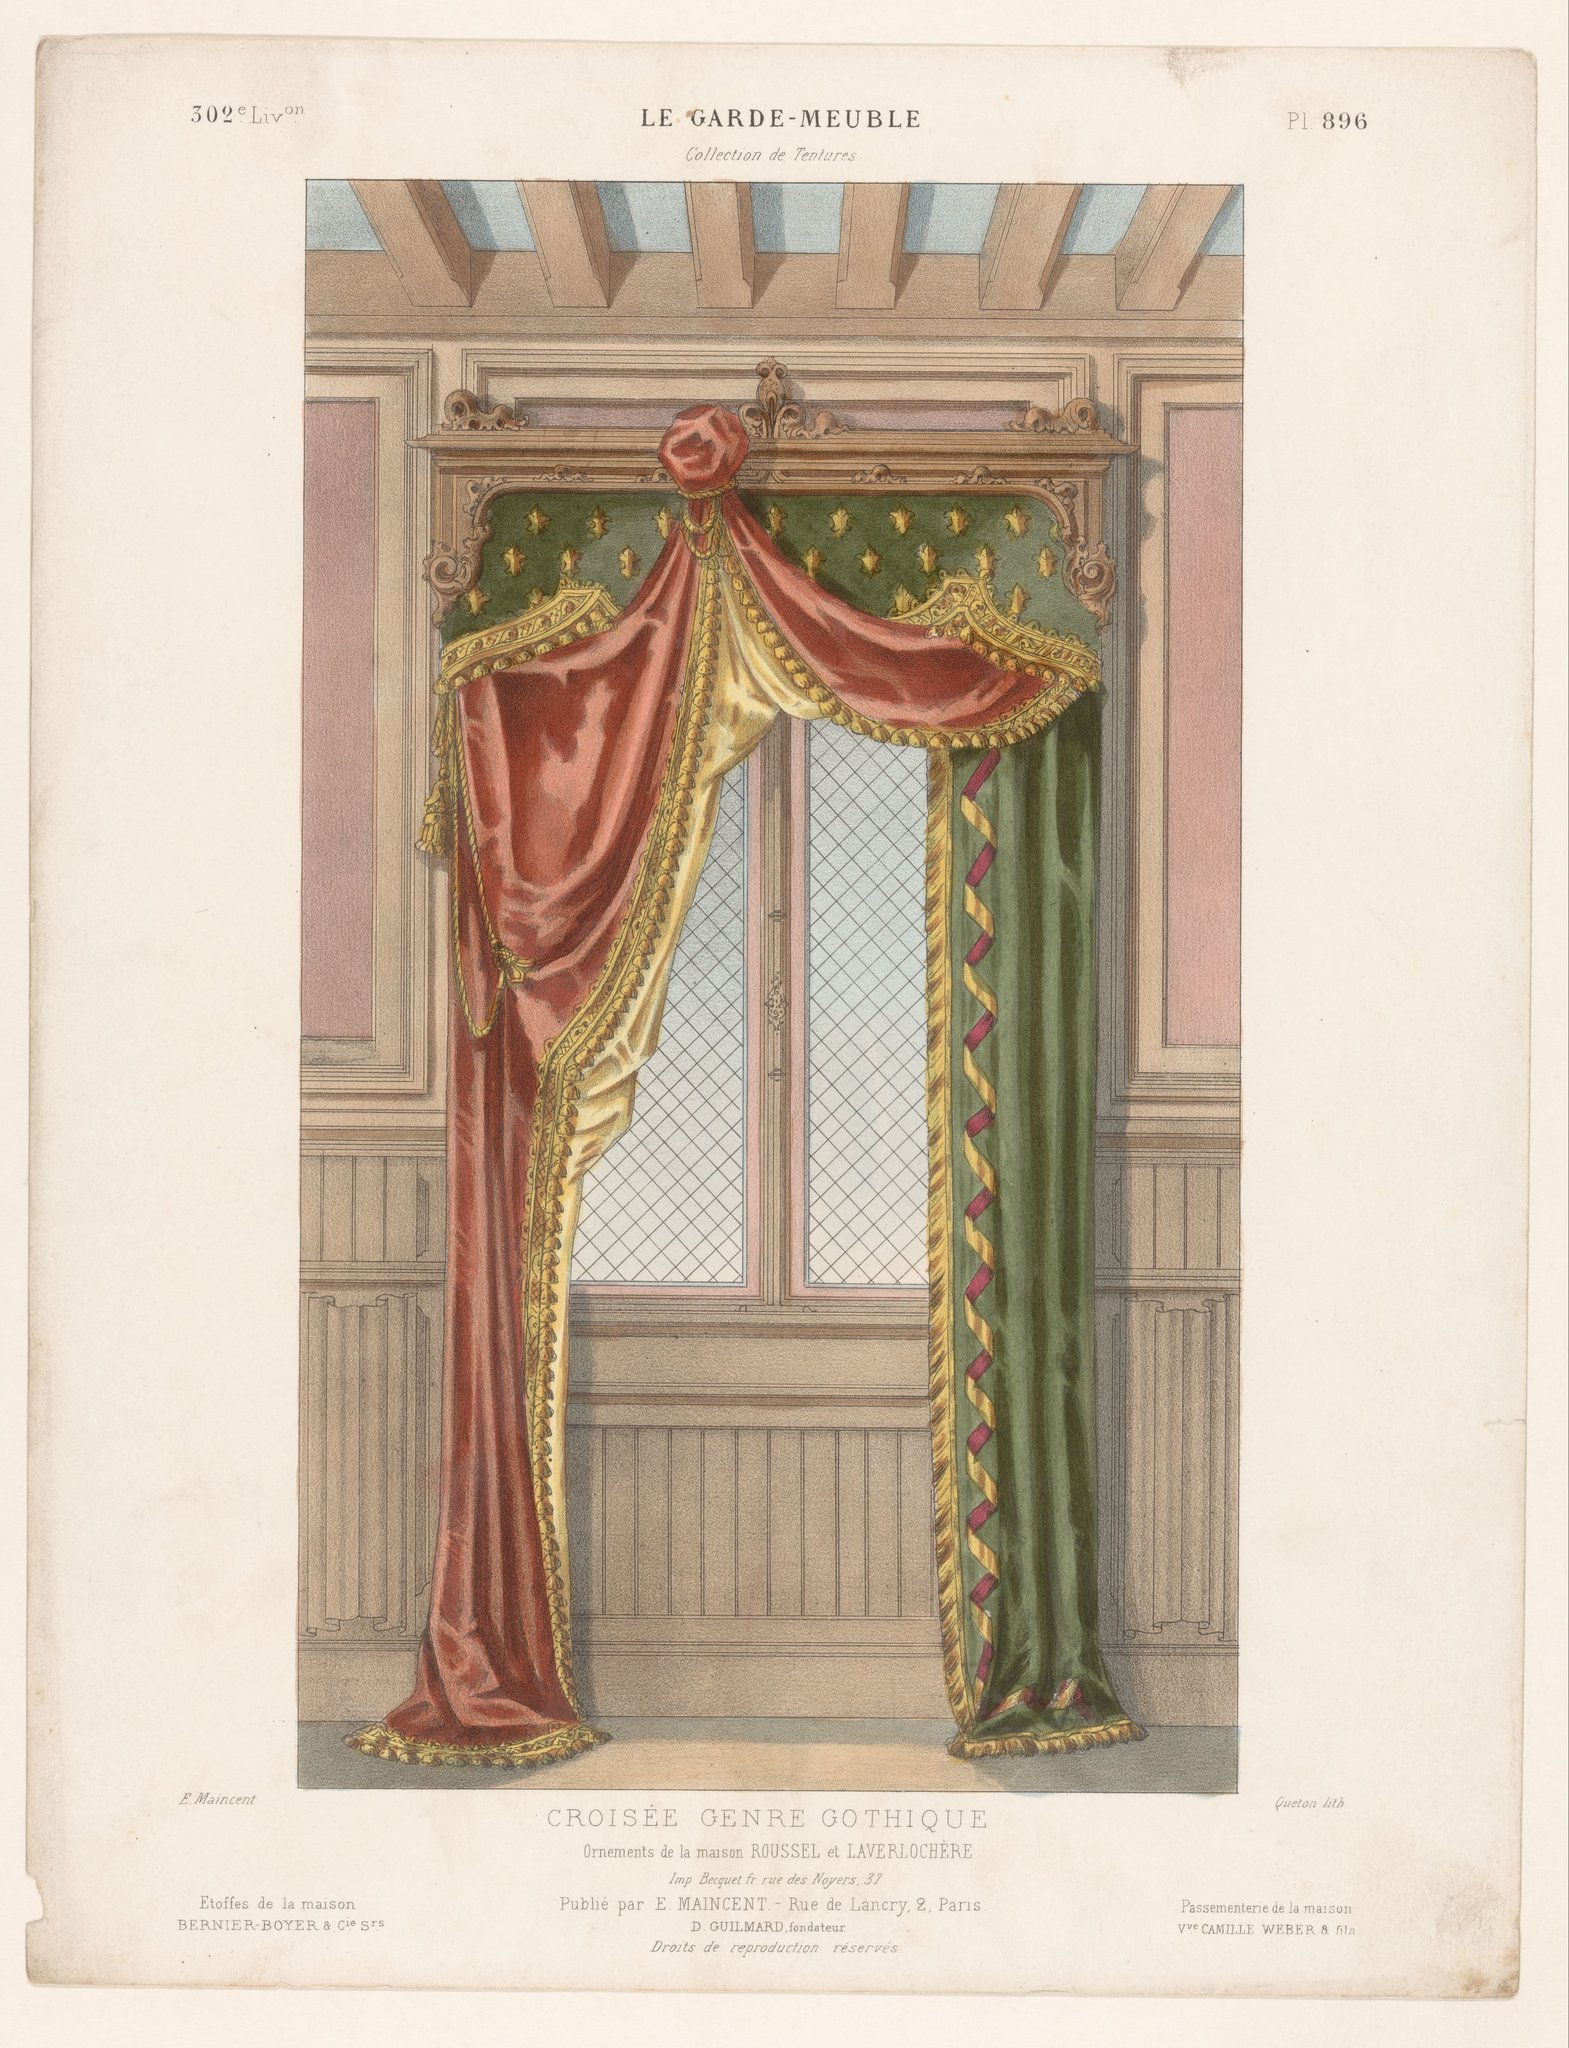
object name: print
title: Venster met gordijnen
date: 1885-1895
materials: paper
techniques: hand coloring, lithograph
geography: paris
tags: window, hangings and drapery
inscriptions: : ‘Droits de reproduction réservés.’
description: Kruisvenster met gordijnen in gotische stijl. Prent uit 302e Livraison.